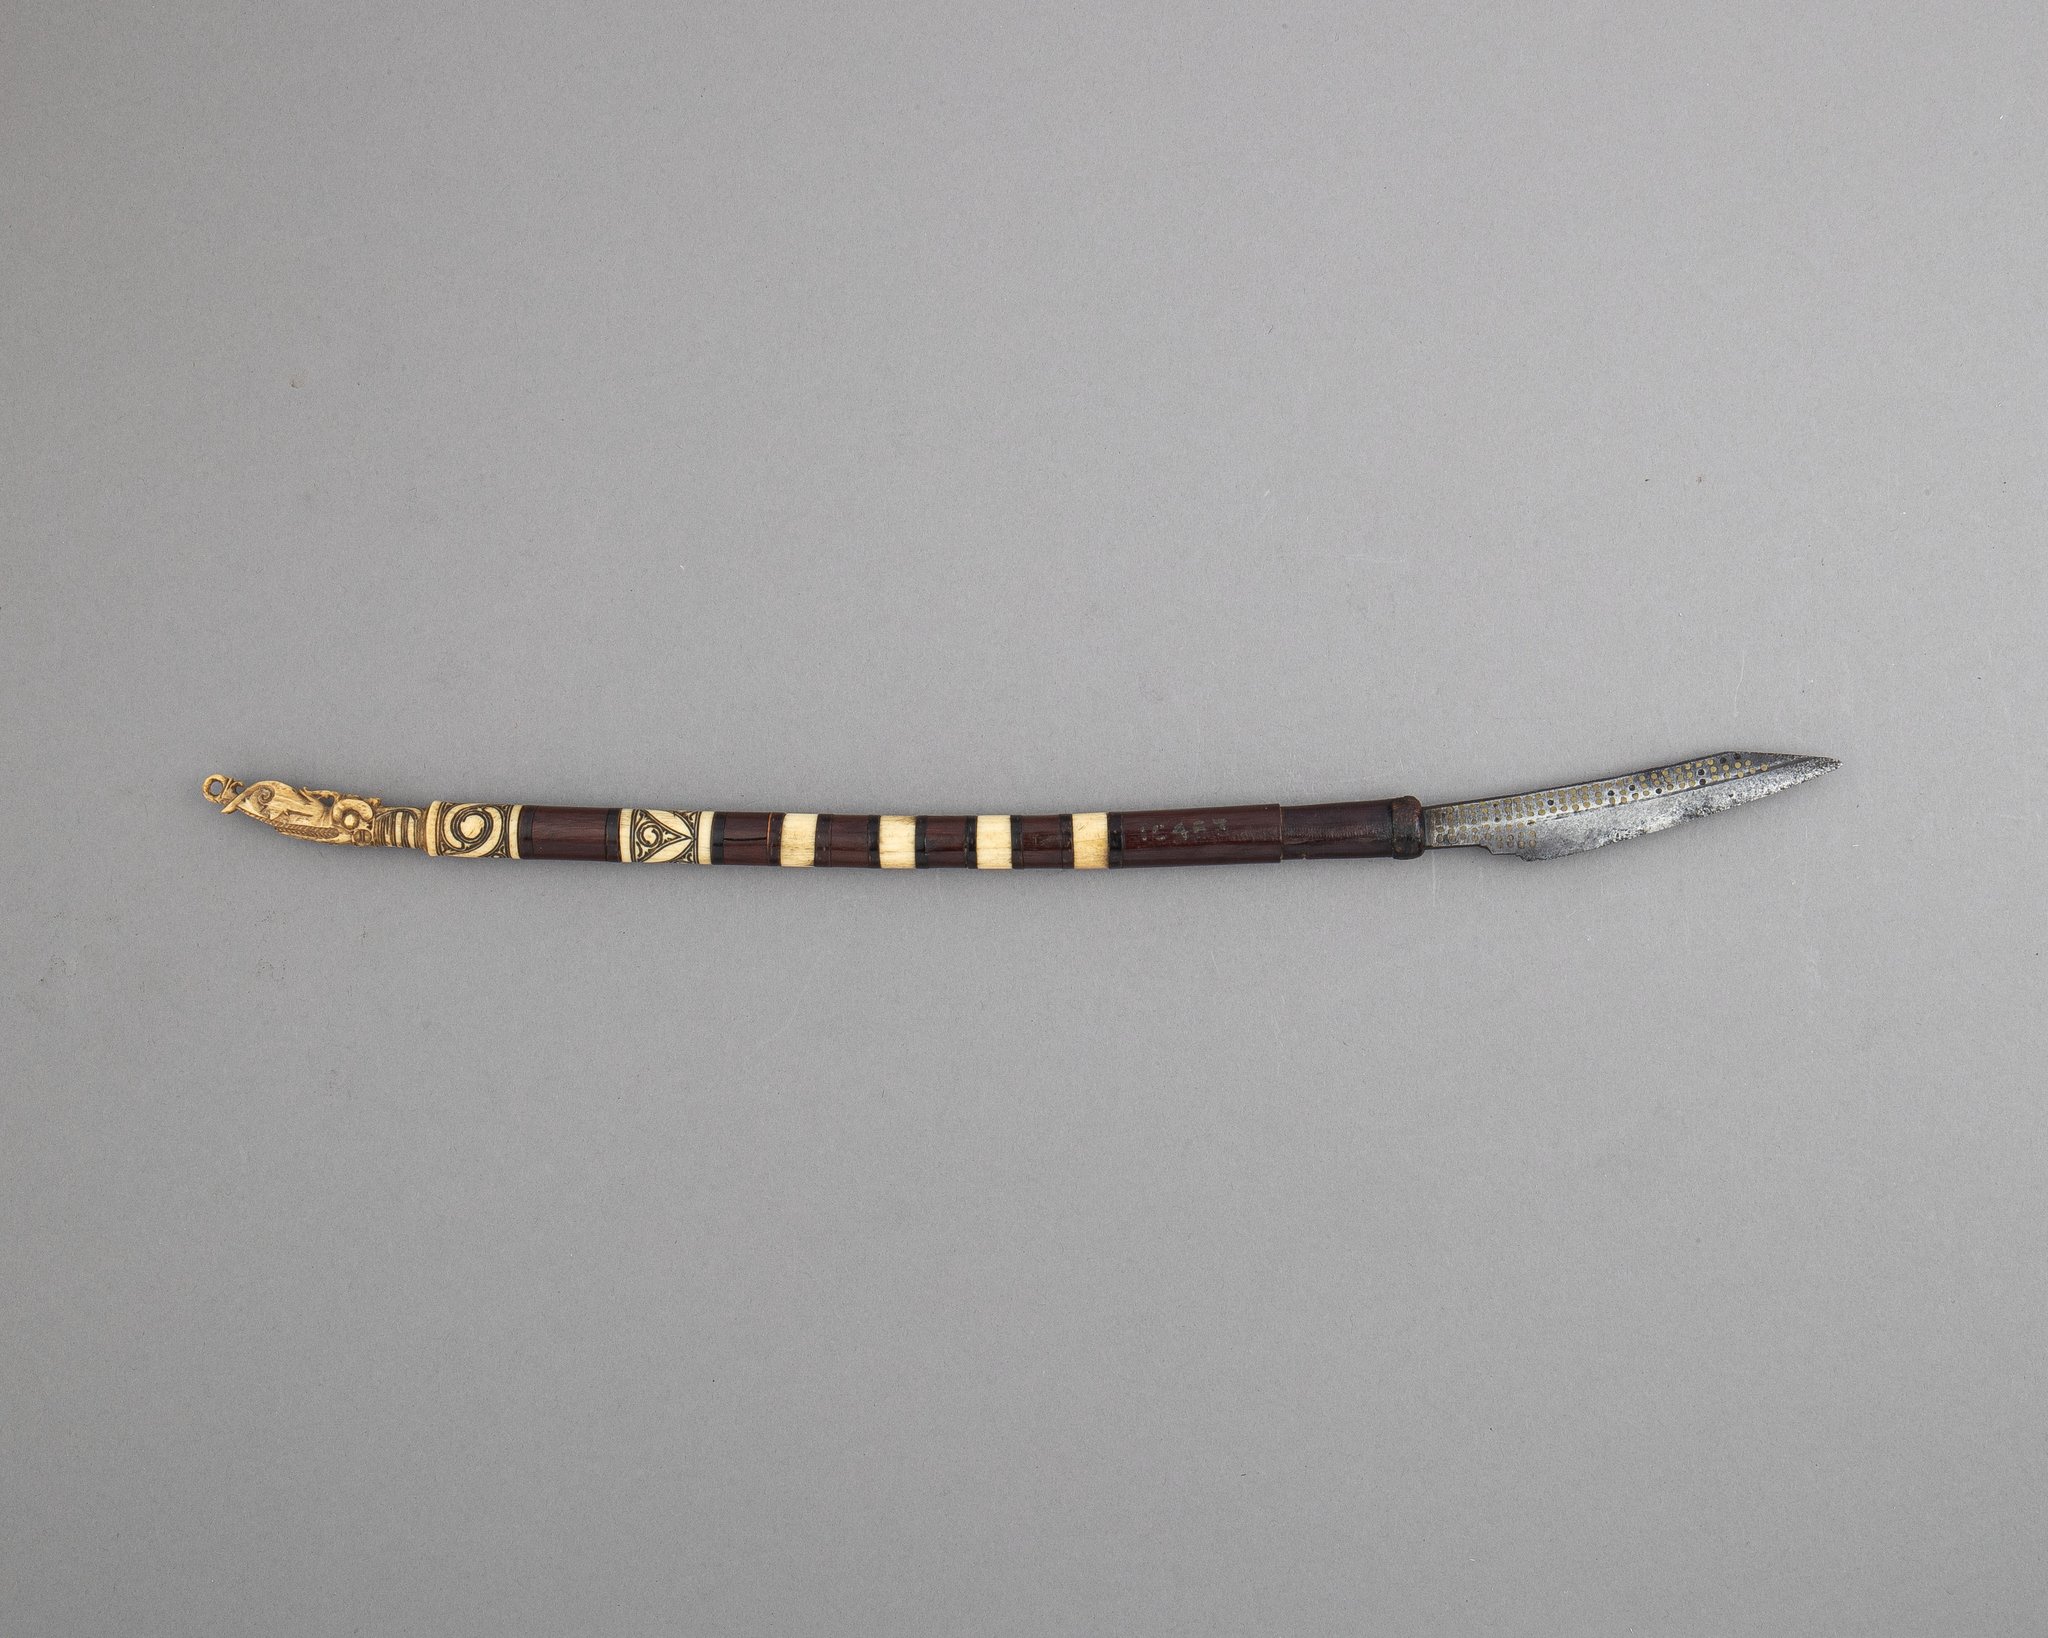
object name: dagger pisau raut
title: Dagger (Pisau Raut)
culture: dyak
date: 1701-1900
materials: bone, horn, steel, wood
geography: malaysia